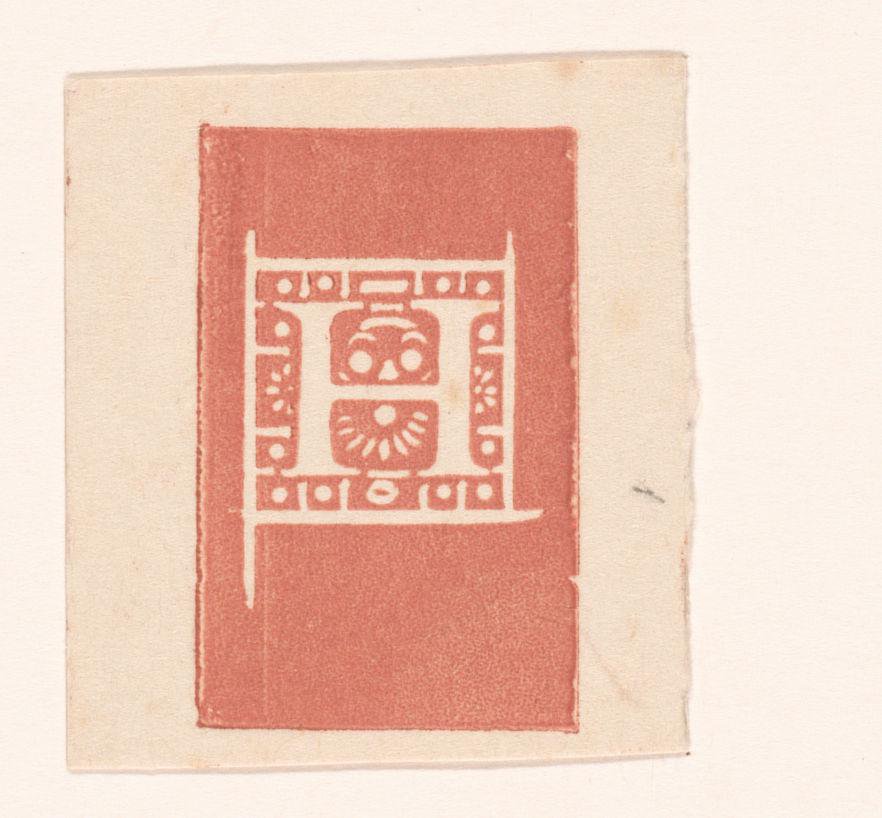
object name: print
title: Letter H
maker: bernard willem wierink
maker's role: draughtsman, print maker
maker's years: 1856-1939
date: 1910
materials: paper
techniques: relief print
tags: letters, alphabet, script, fable of reynard the fox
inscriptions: collector's mark: Lugt 2228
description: Ontwerp voor: Streuvels, Stijn (Frank Lateur). Reinaert de Vos naar verschillende uitgaven van het middeleeuwsche epos. Amsterdam: L.J. Veen, 1910. Deze prent is vermoedelijk een plaatsnede, ook al wordt in de literatuur veelal gesproken over een houtsnede. Voor zover Wierink zijn prenten in hoogdruk zelf nader heeft omschreven, heeft hij altijd de term 'plaatsnede' gebruikt.